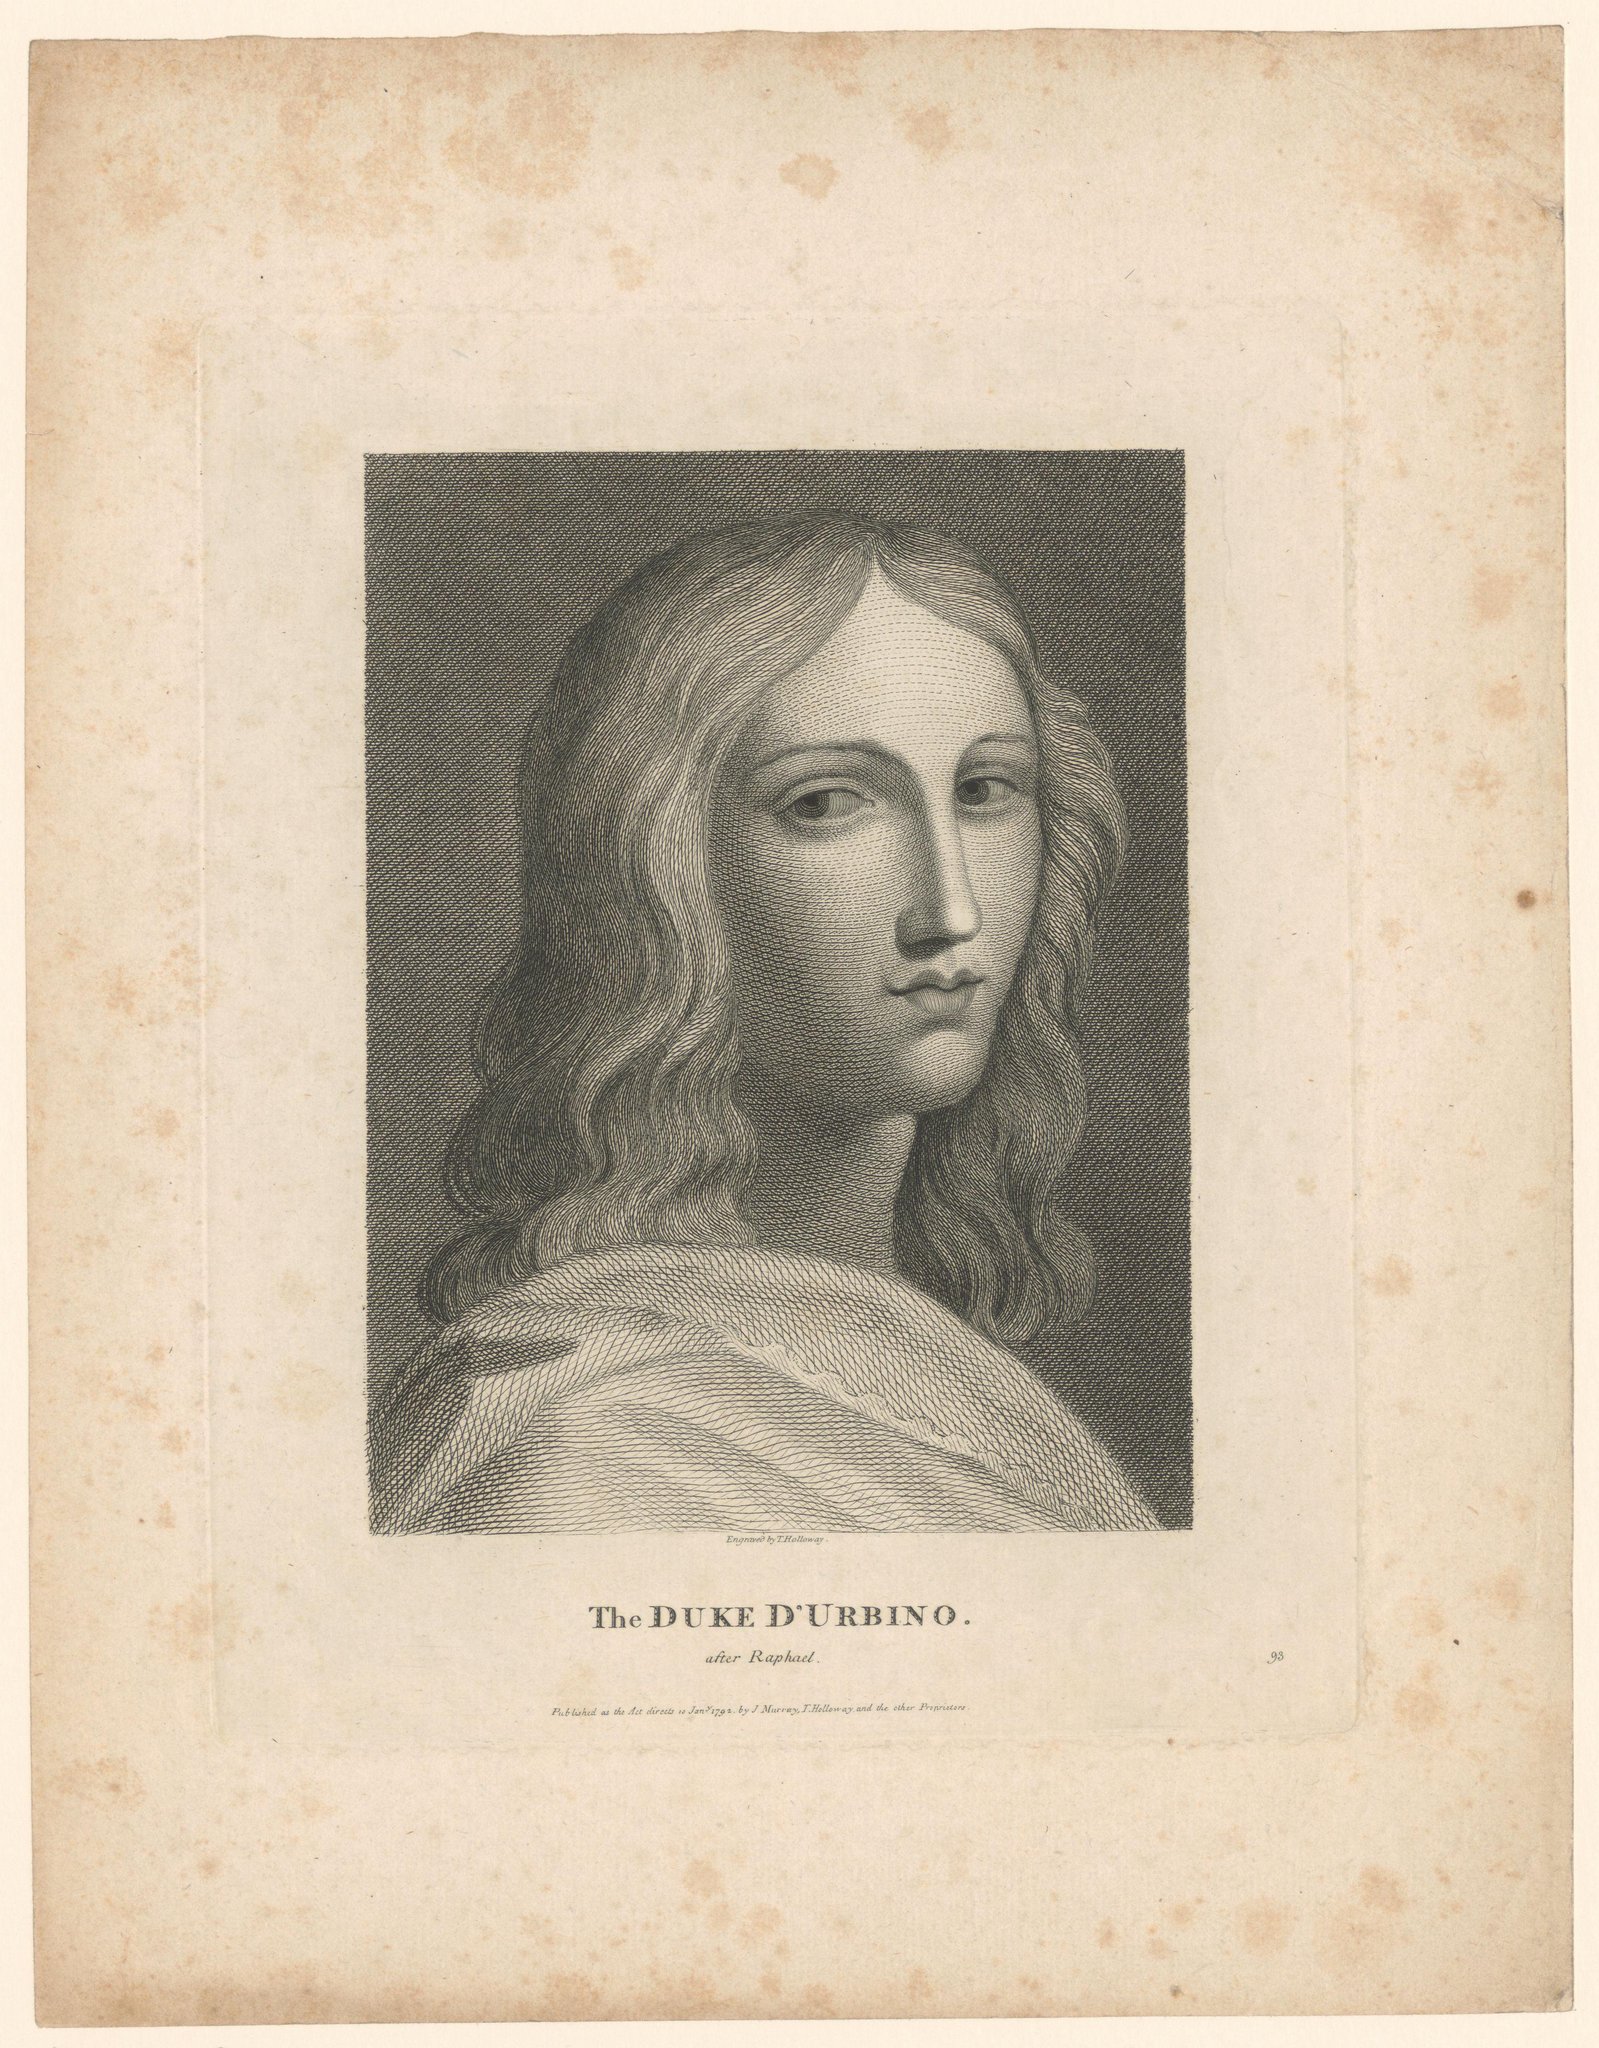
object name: print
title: Portret van Francesco Maria I della Rovere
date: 1792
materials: paper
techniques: engraving, etching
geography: london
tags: francesco maria i della rovere (duke of urbino), commander-in-chief, general, marshal, historical persons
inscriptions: collector's mark: Lugt 2228